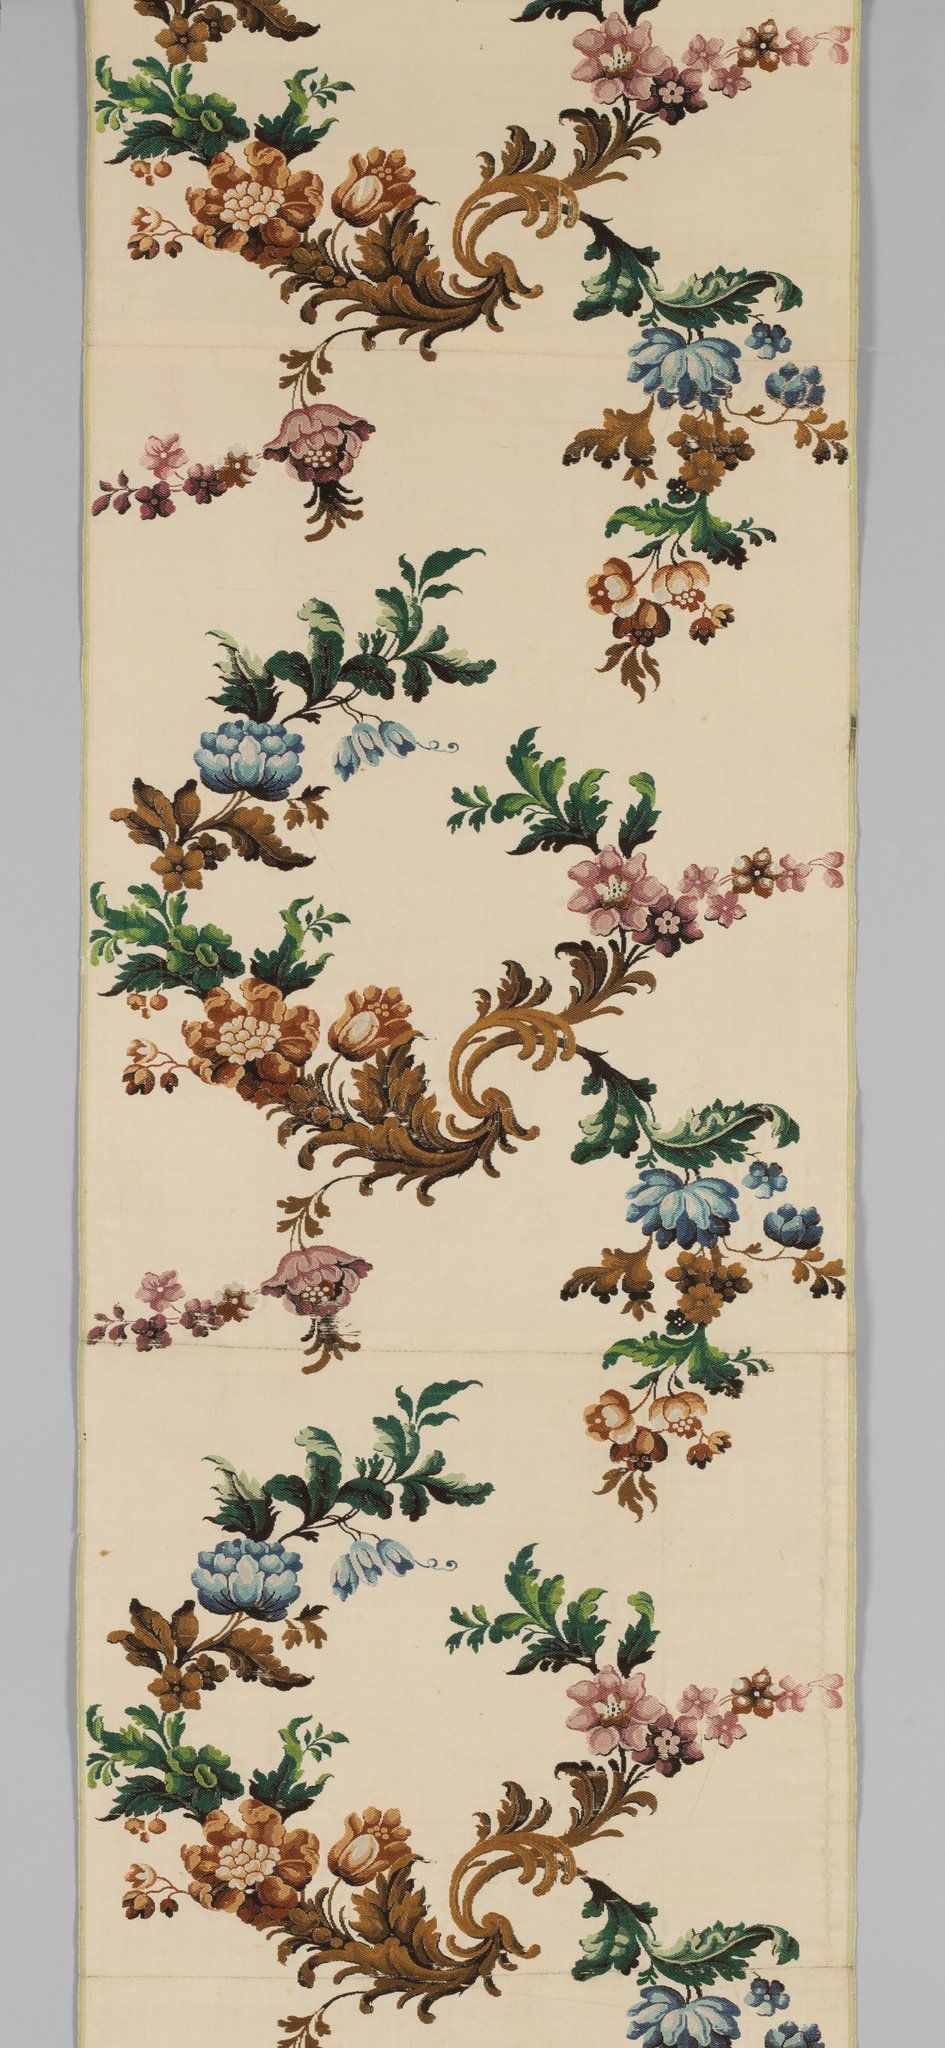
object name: piece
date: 1740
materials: silk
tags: flowers,leaves